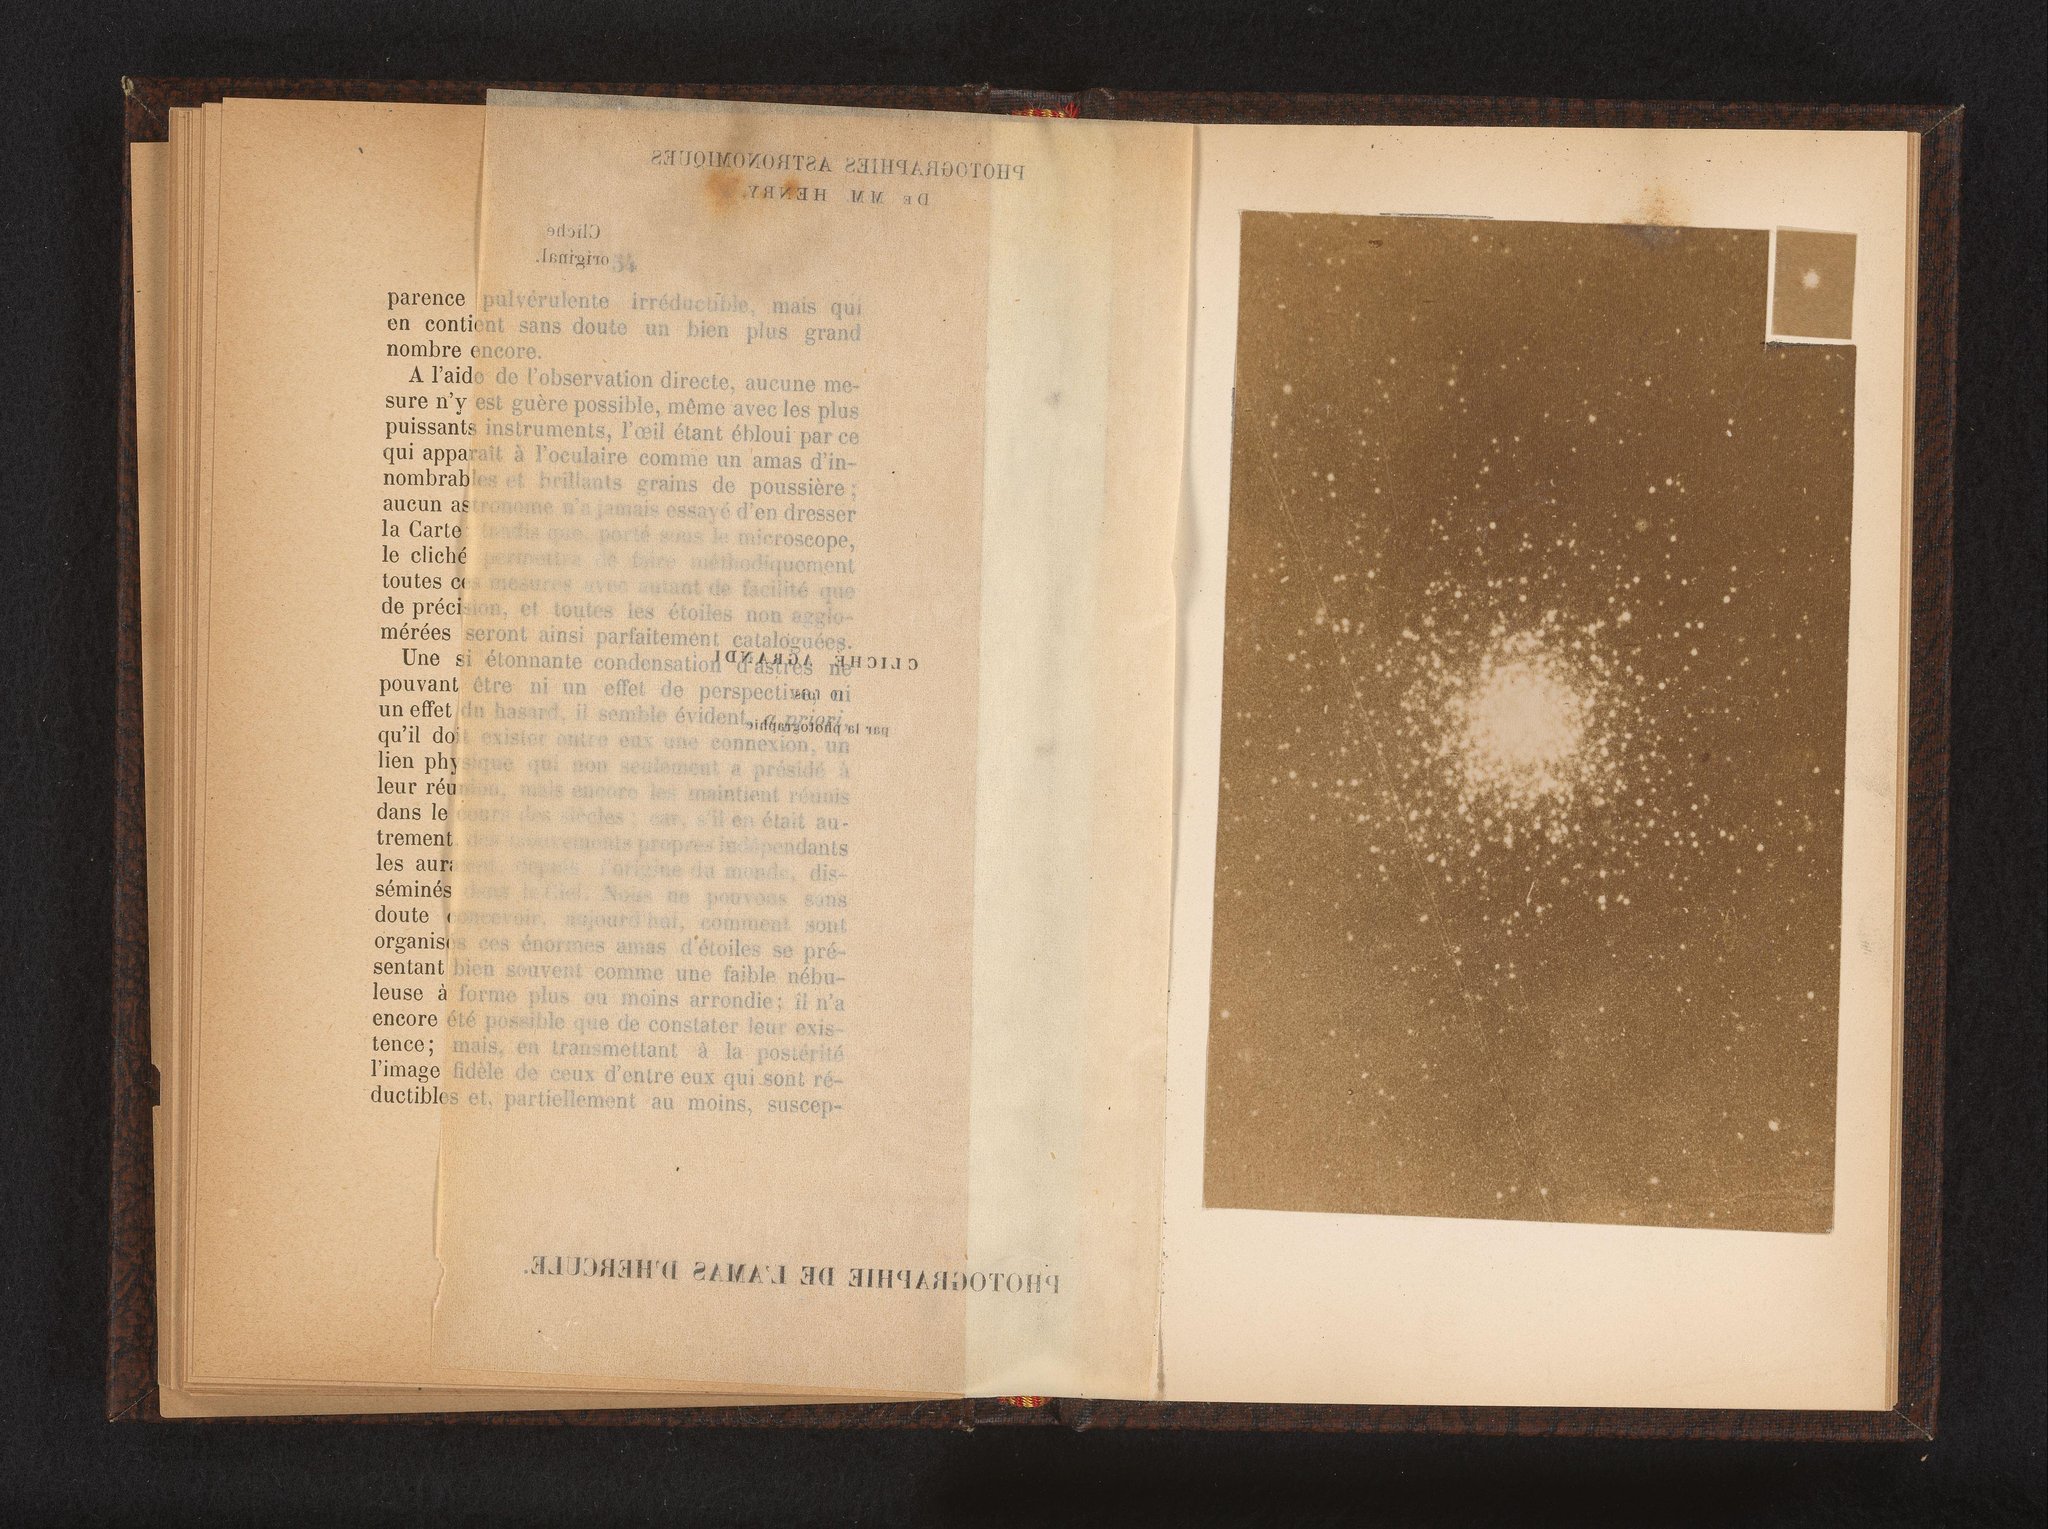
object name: page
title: Photographie de l'amas d'Hercule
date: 1882-1887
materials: paper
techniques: albumen print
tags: stars and constellations